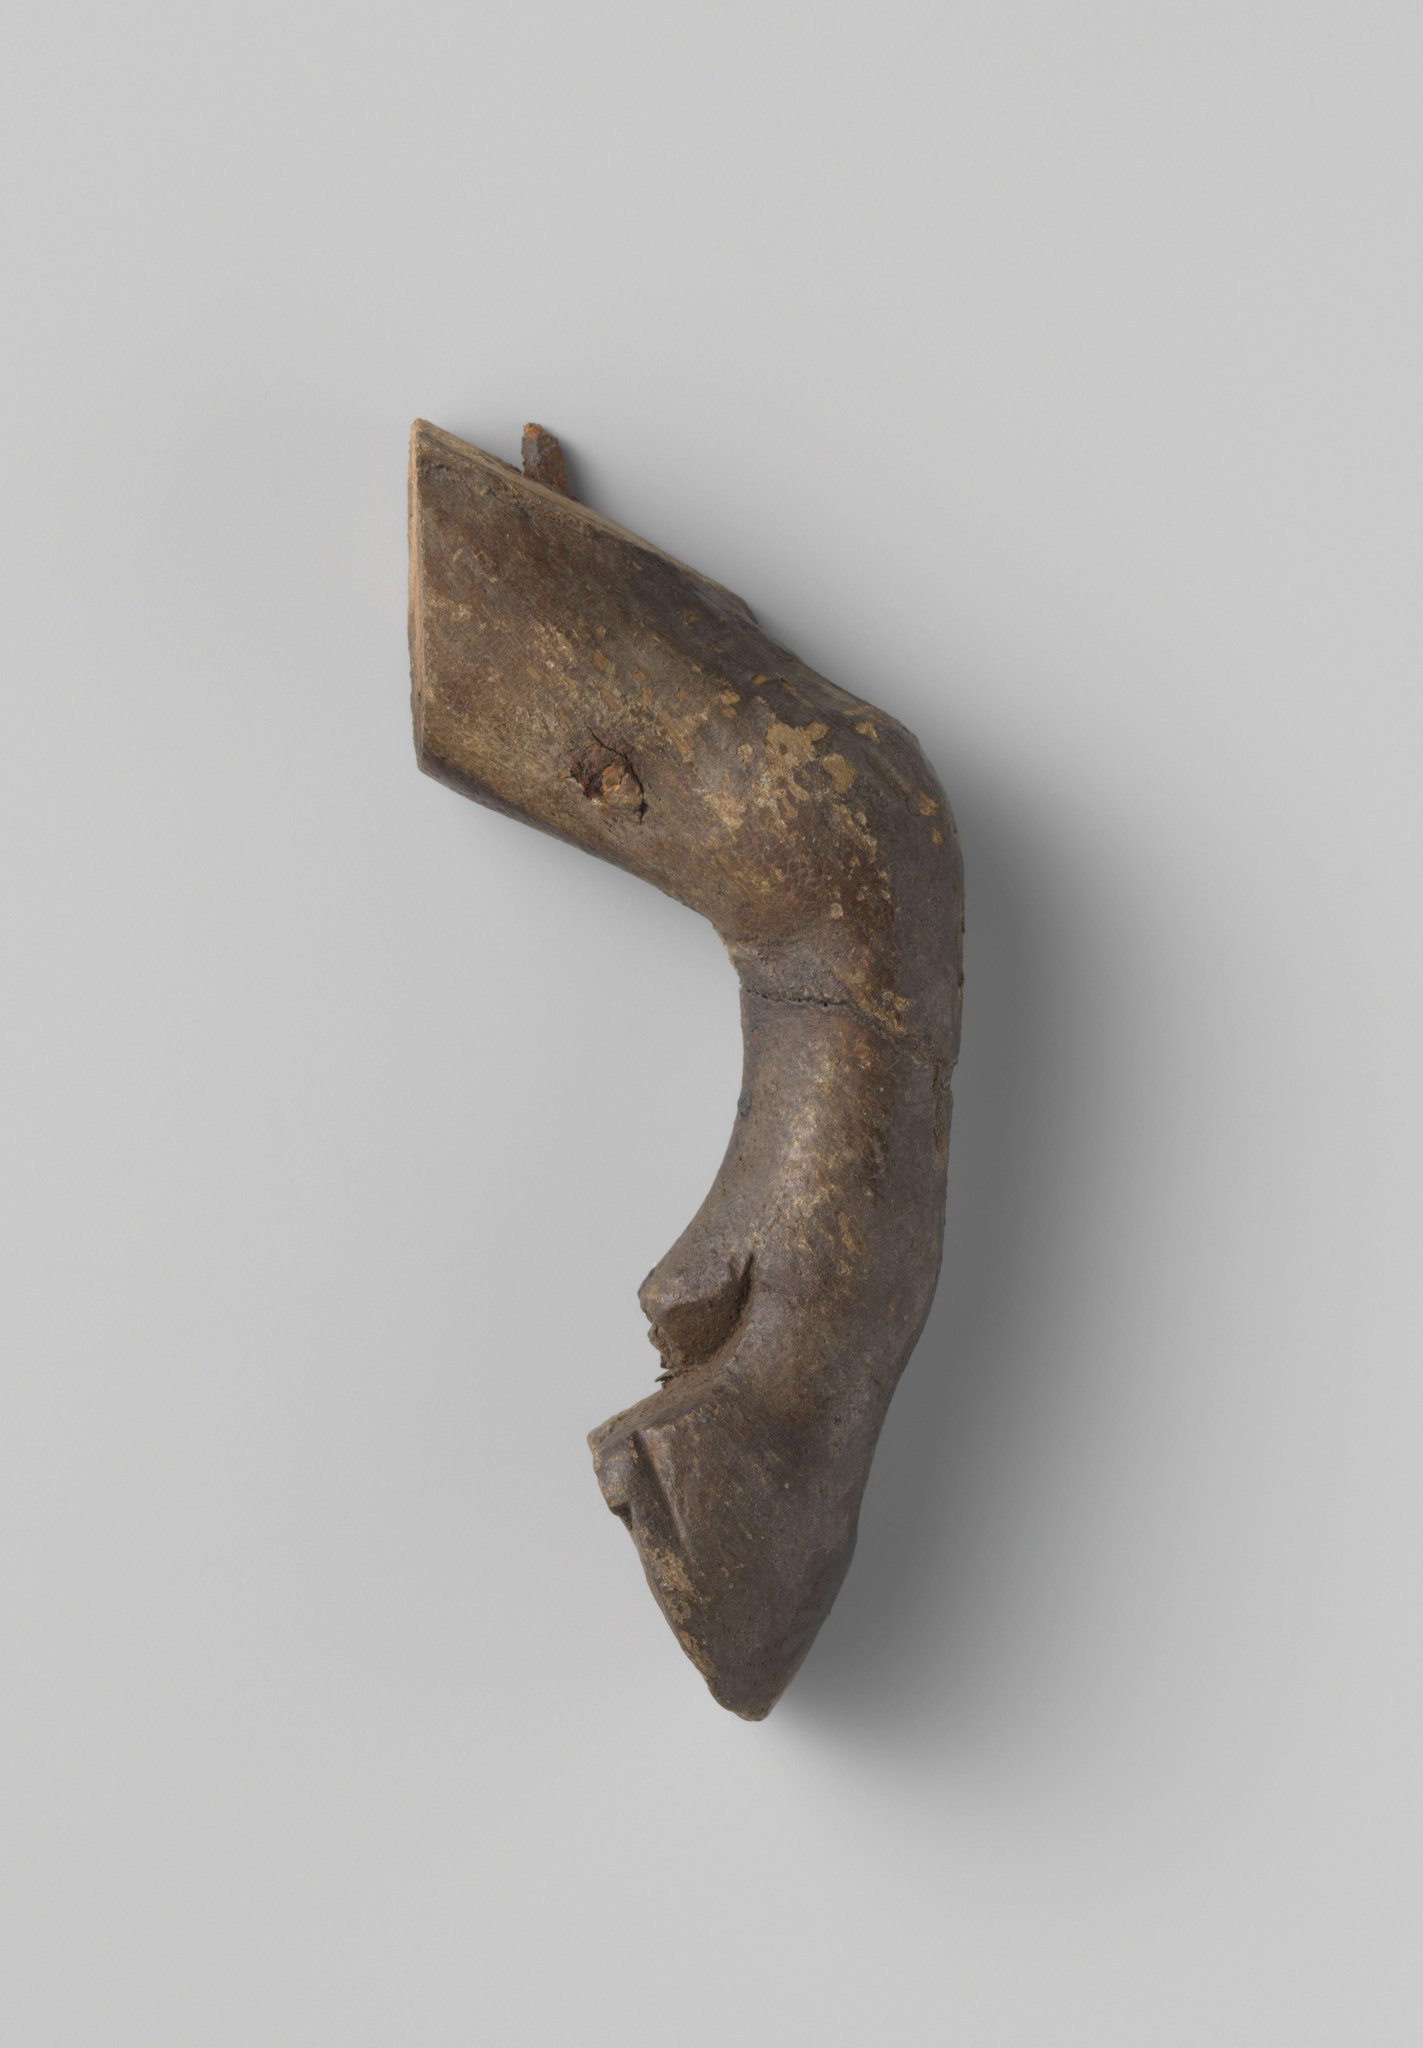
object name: fragment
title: The Meeting of the Magi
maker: Anonymous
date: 1800-1900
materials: wood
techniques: cutting, polychromy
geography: netherlands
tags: the three wise men meet at the crossroads, den bosch